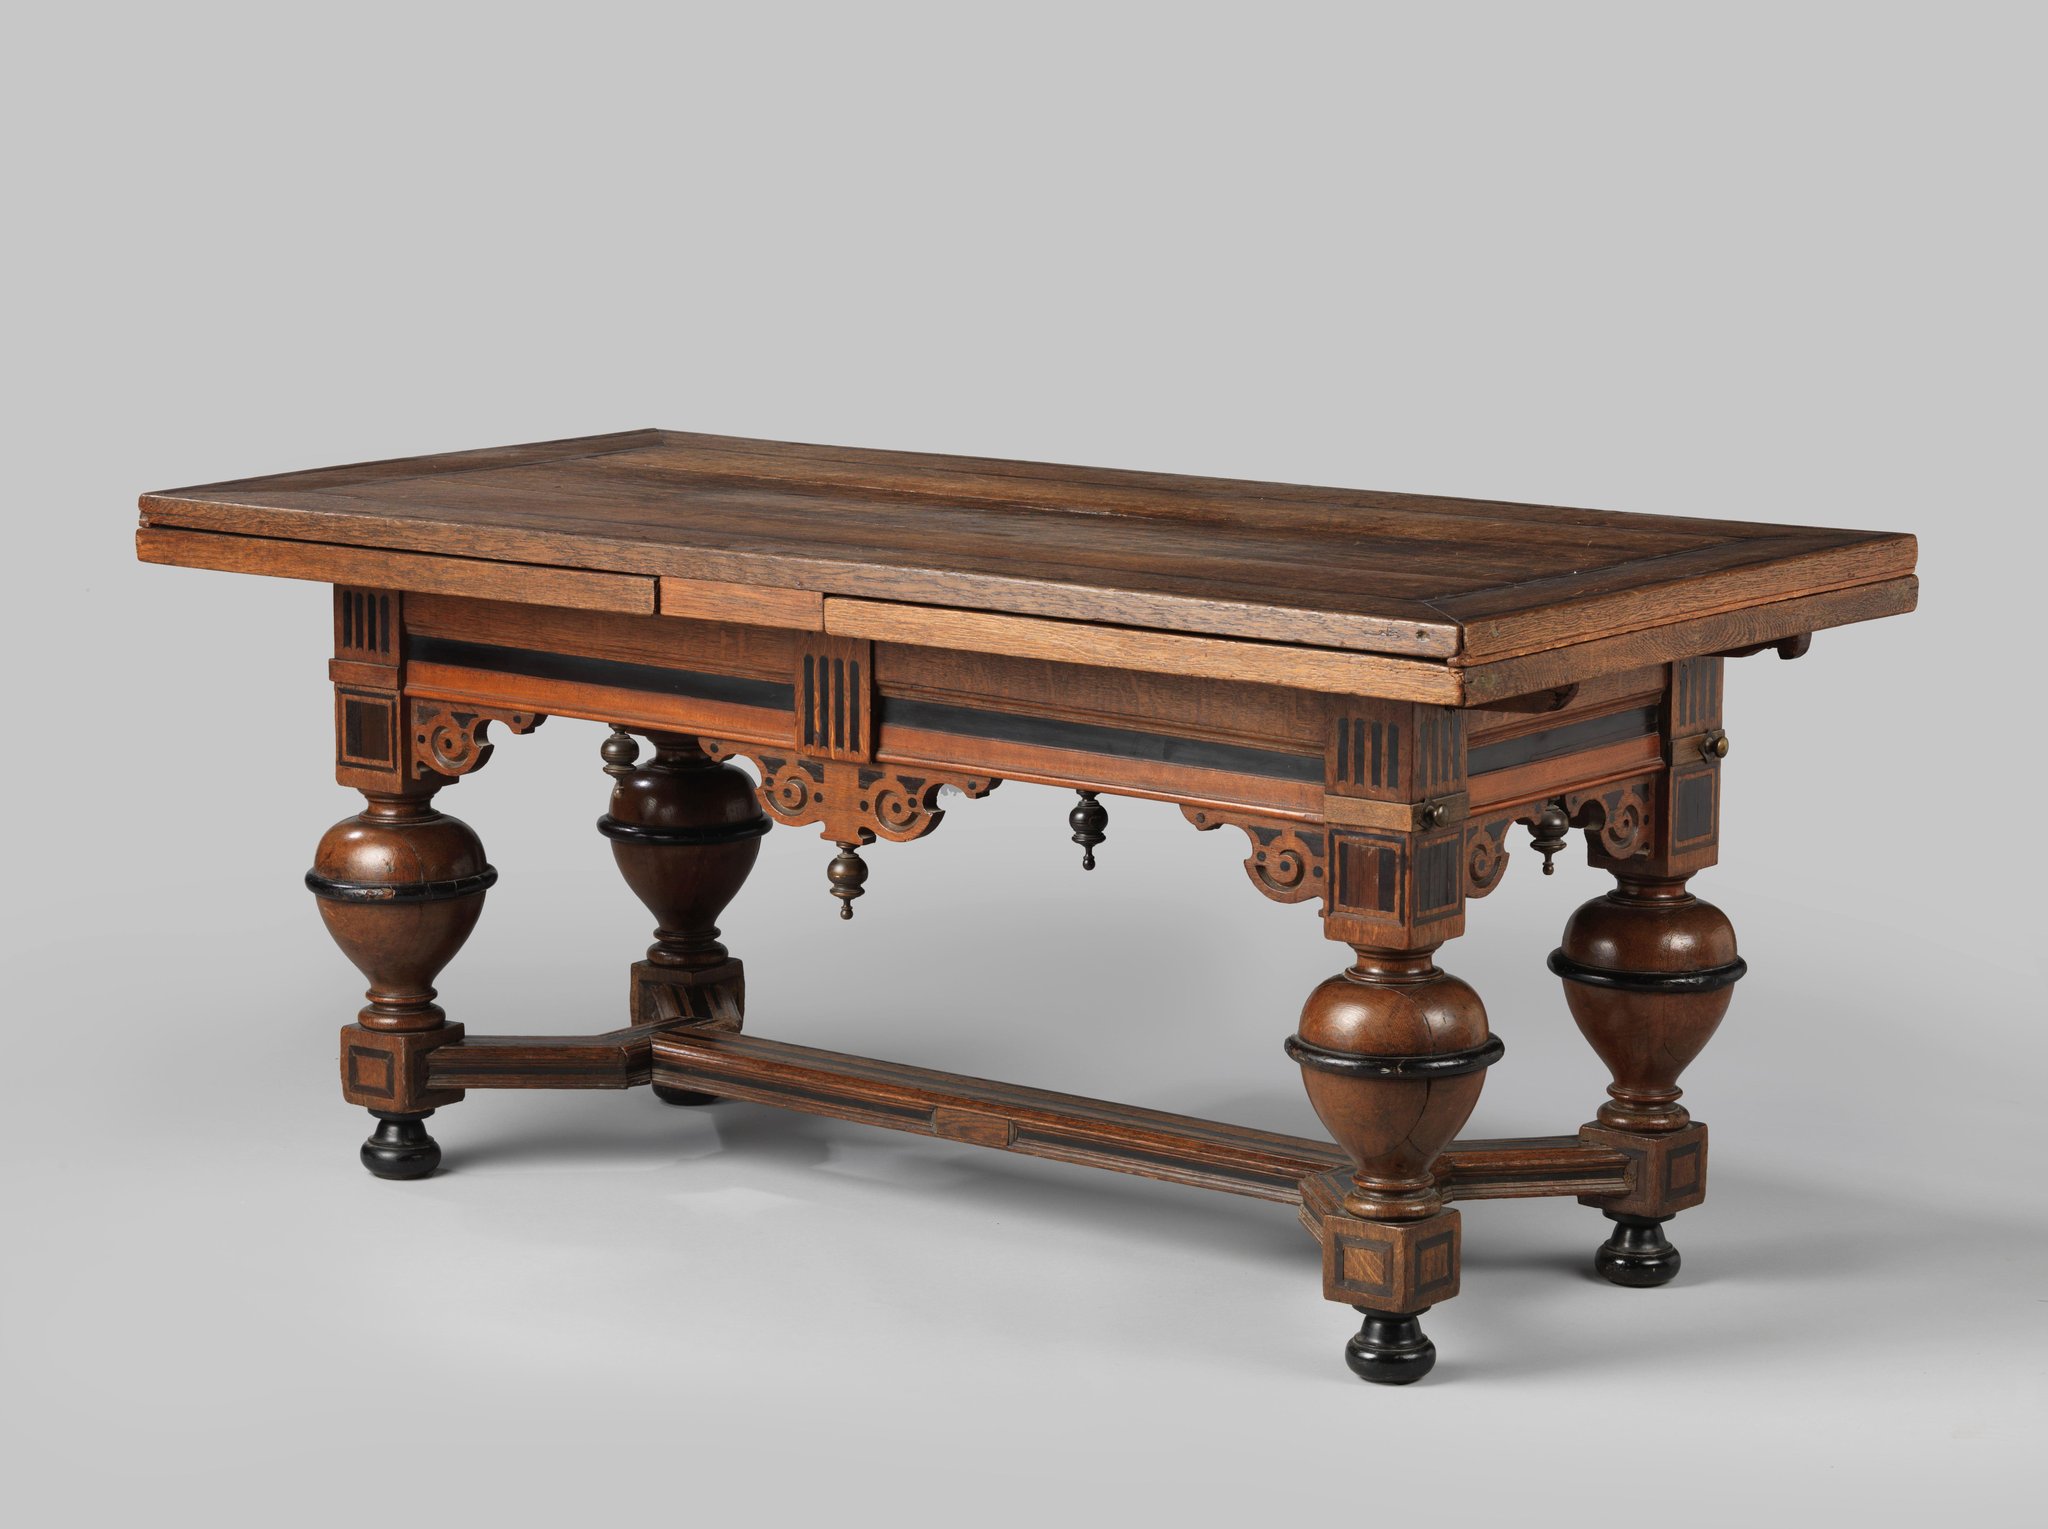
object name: table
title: Tafel met trekbladen; eiken- met ebbenhout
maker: Anonymous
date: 1640-1660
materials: wood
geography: northern netherlands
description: Tafel van eikenhout, versierd met ebbenhout. Het meubel heeft poten die dikke peervormige geledingen met huizen vertonen en door een dubbel Y-vormig kruis verbonden zijn. De regels hebben een gedraaide ebbenhouten druiper. Op de huizen van de poten, de steunstukken en in het blad zijn ebben banden aangebracht. De tafel heeft twee trekbladen en ledikantschroeven boven aan de poten en aan het kruis.